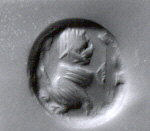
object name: stamp seal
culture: sasanian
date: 401-700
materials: stone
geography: iran